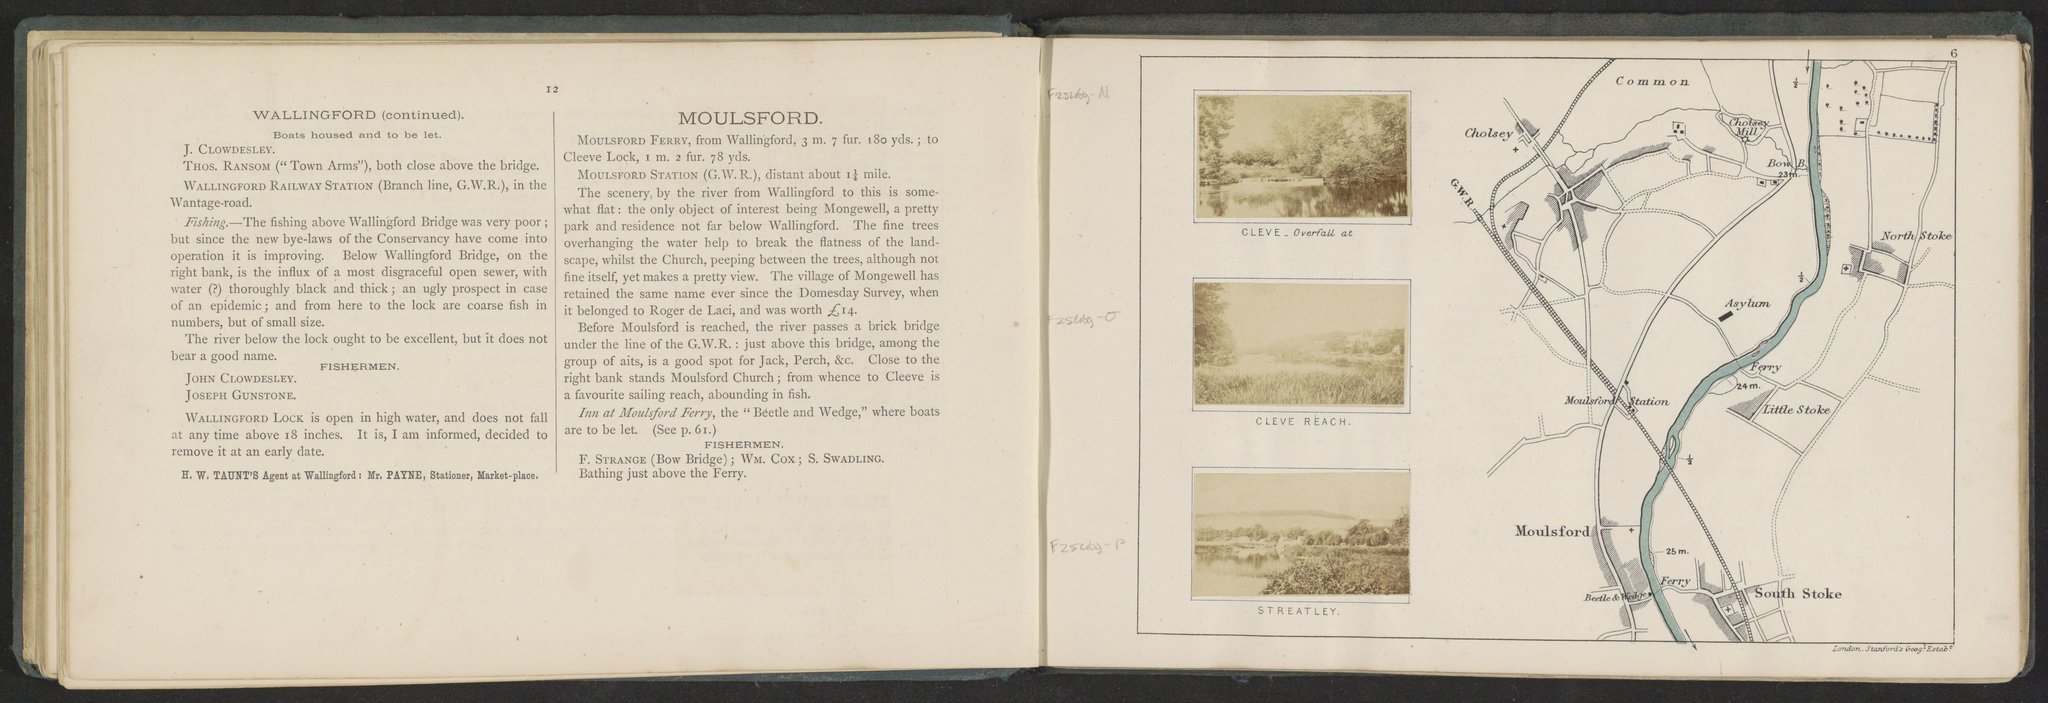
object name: page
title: Gezicht op Streatley over de Theems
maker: henry w. taunt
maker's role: fotograaf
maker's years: 1842-1922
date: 1871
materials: photographic support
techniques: albumen print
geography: streatley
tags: river, thames